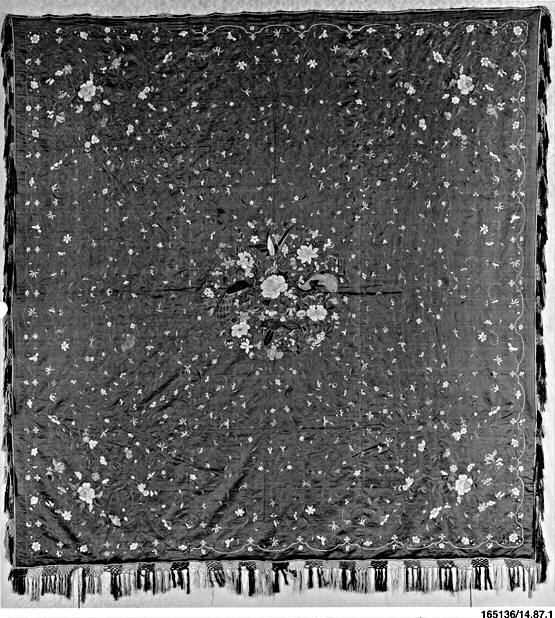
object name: bedspread or cover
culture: chinese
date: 1801-1900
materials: silk